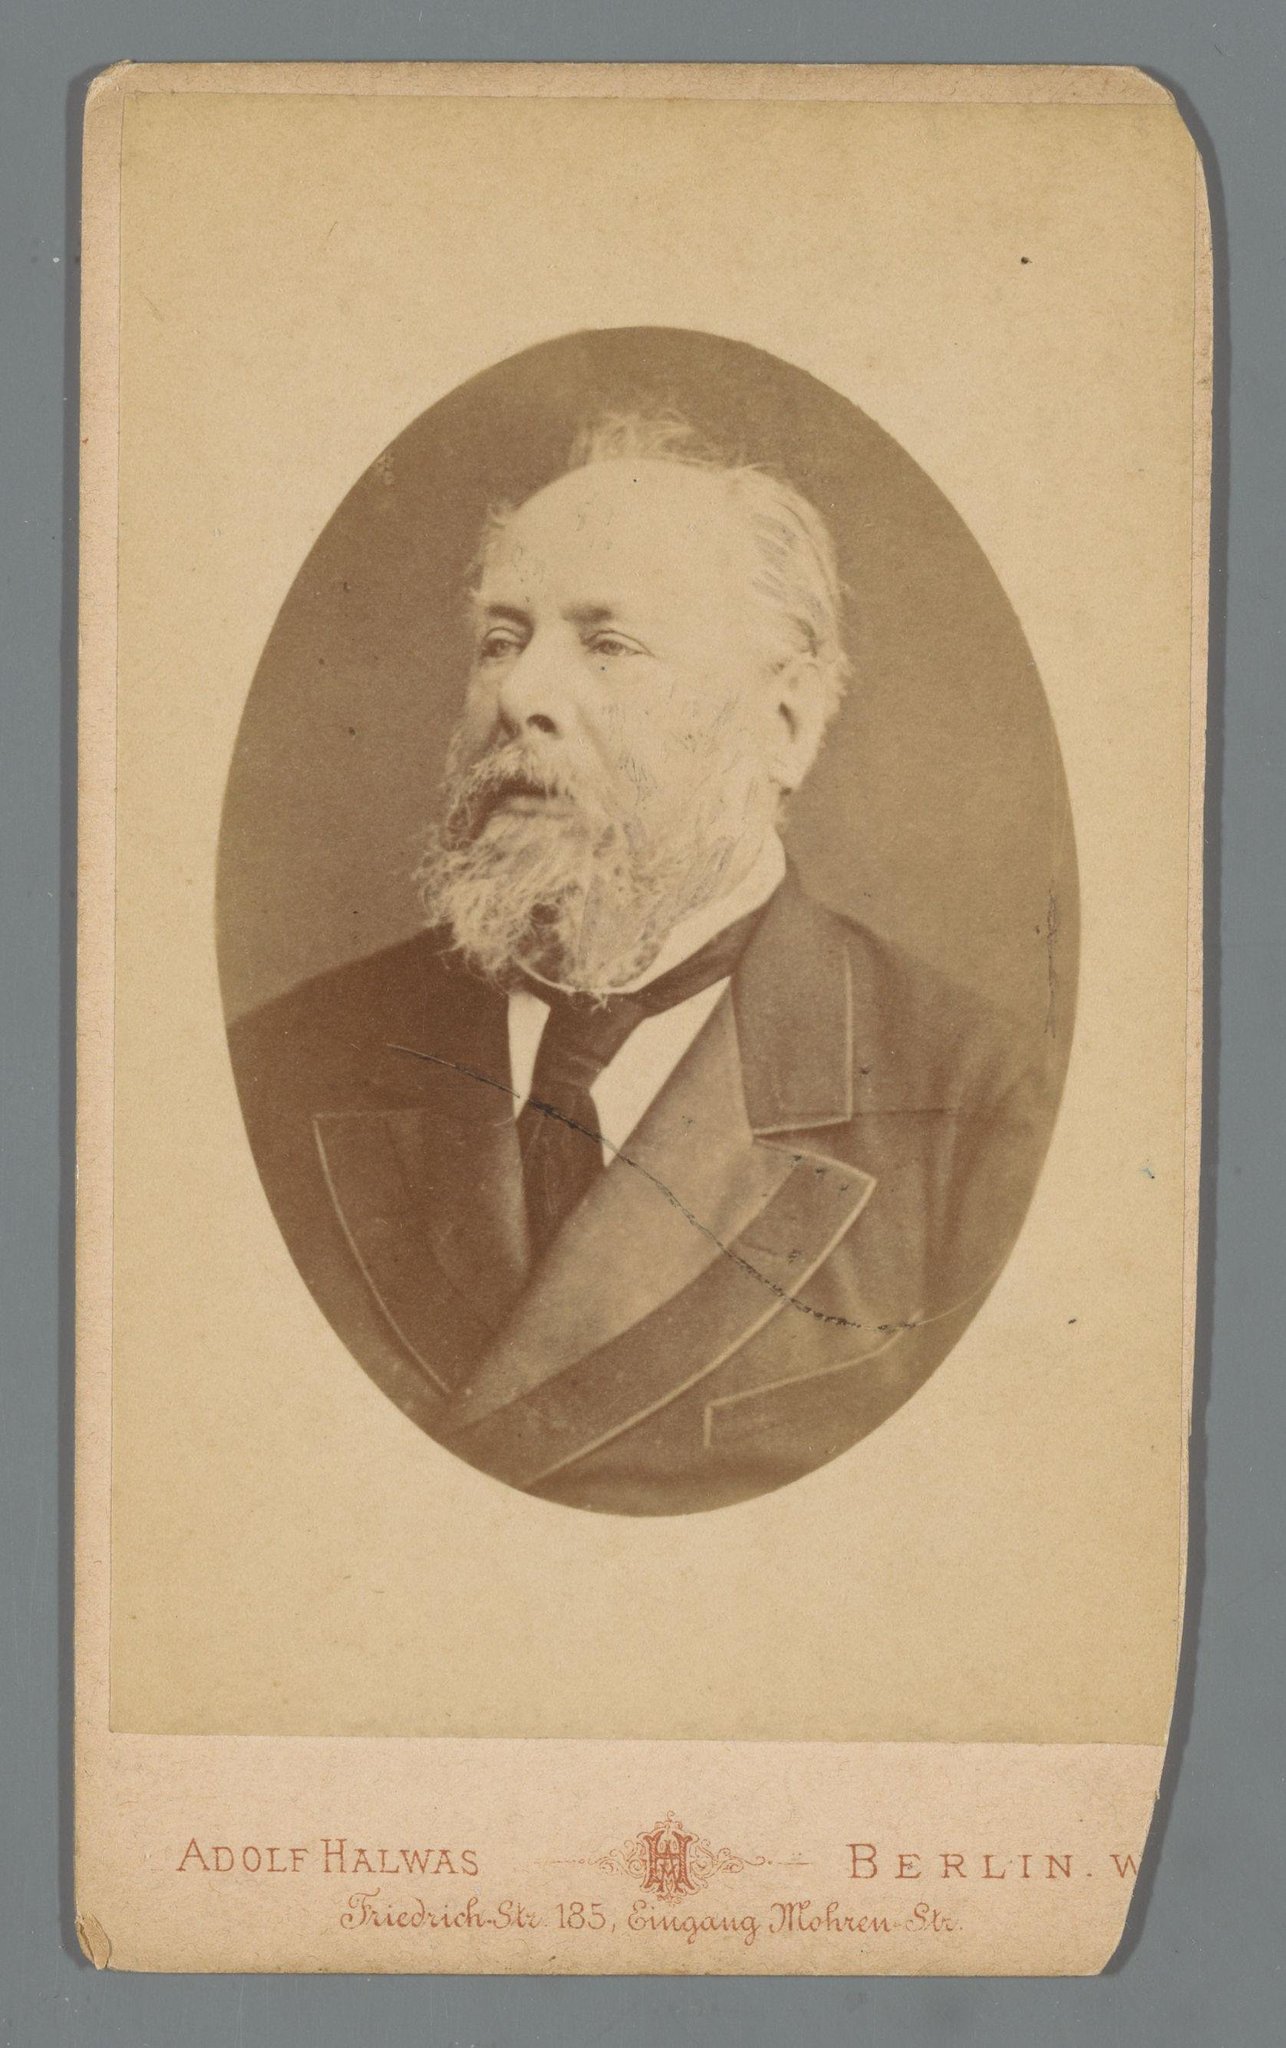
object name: carte de visite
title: Portret van koning Willem III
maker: adolf halfwas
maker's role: fotograaf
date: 1865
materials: cardboard, photographic support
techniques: albumen print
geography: berlin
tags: brussels, willem iii (koning der nederlanden)